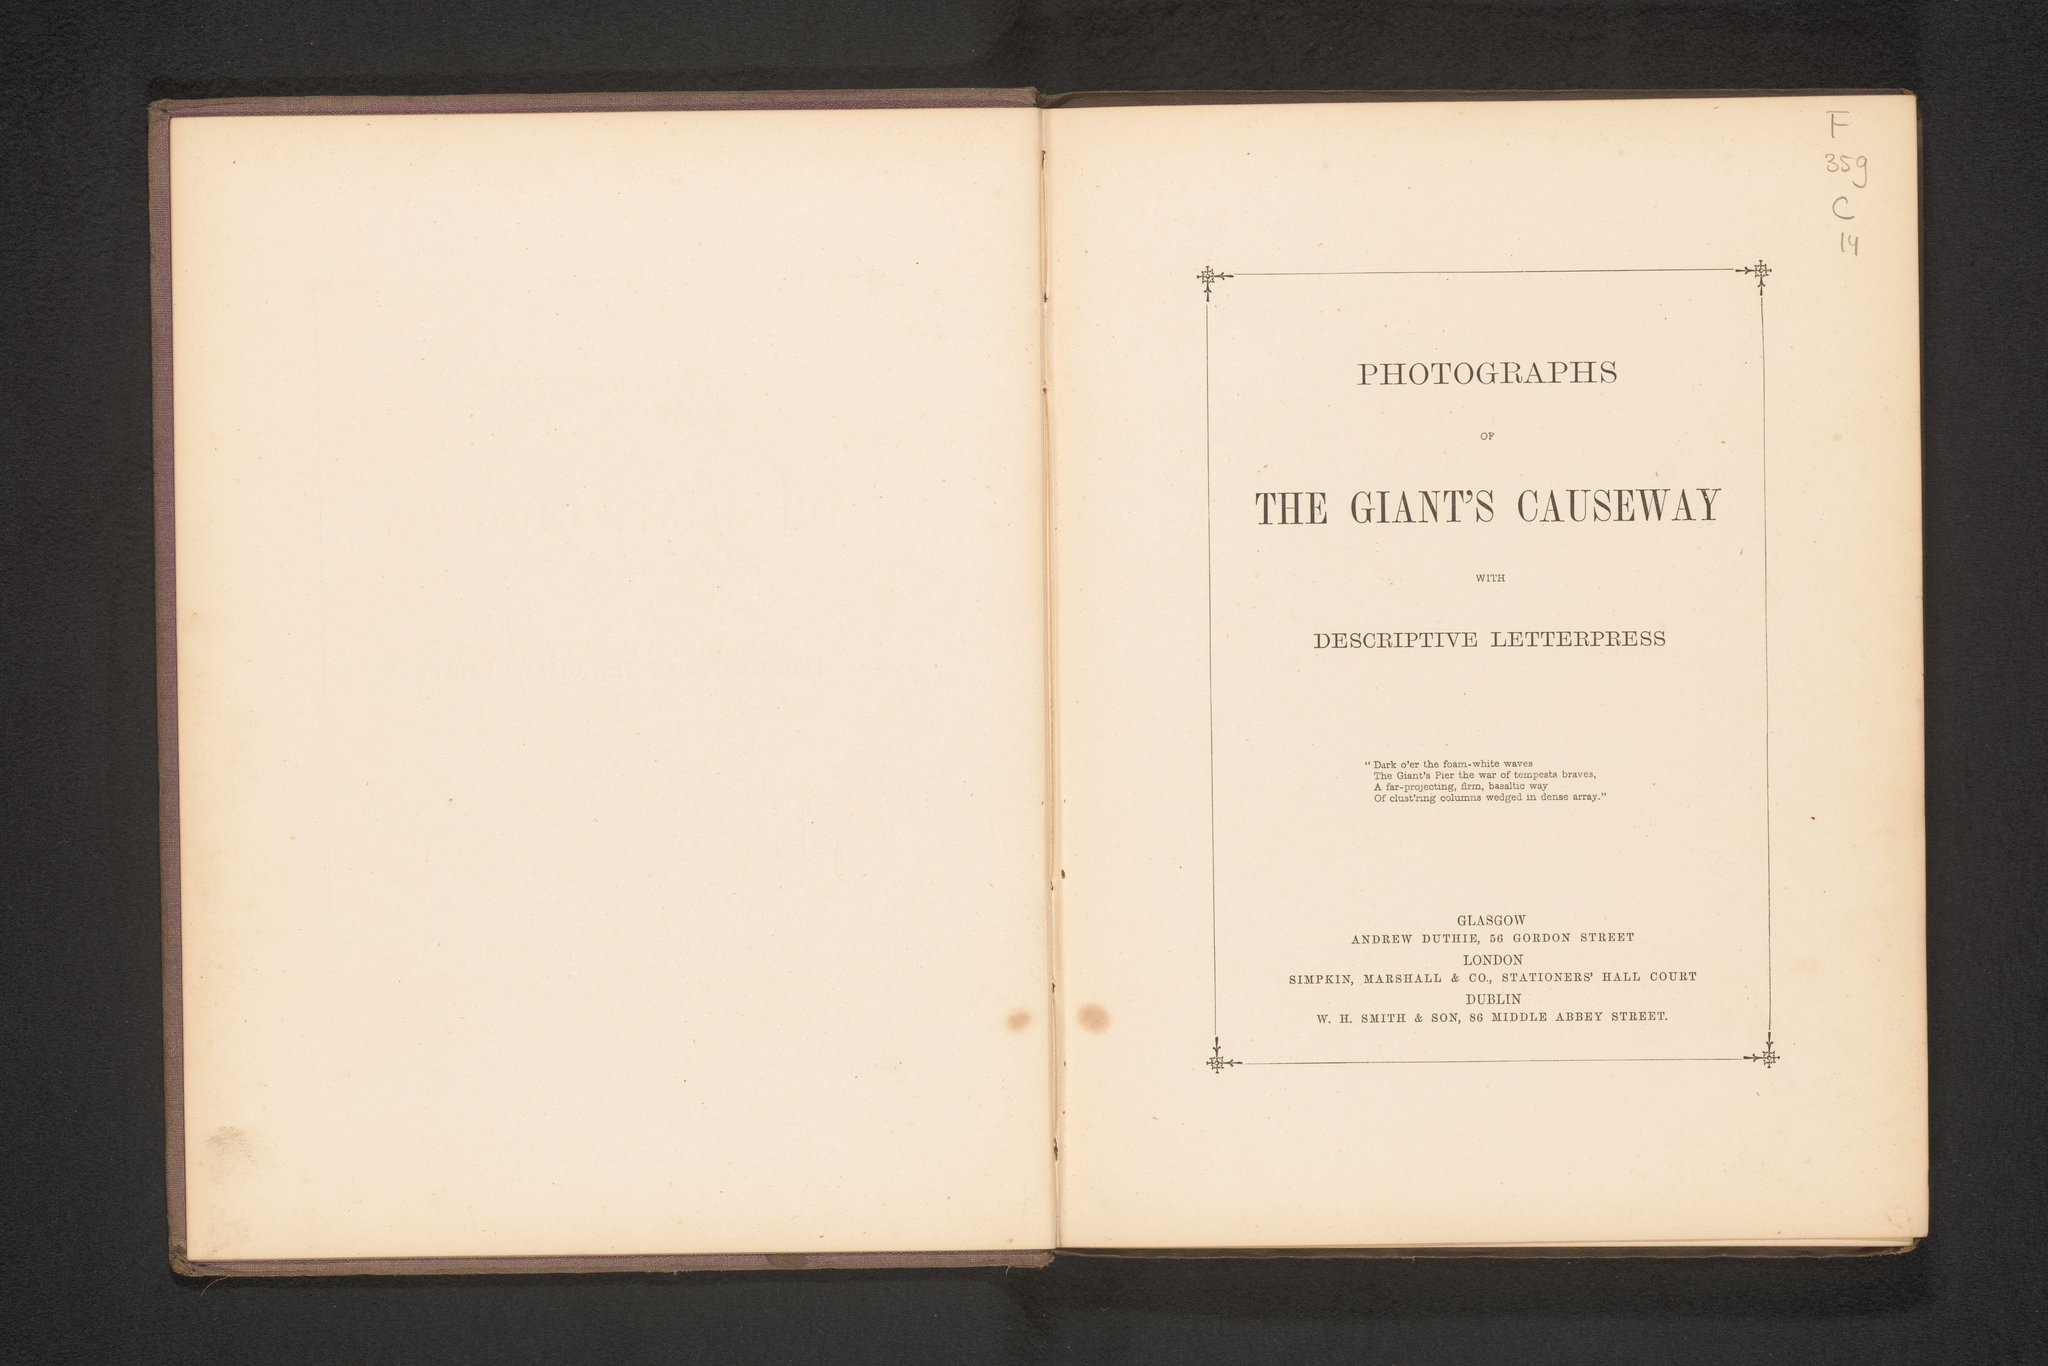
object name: book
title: Photographs of the Giant's Causeway with descriptive letterpress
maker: andrew duthie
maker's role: publisher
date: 1867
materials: cardboard, paper, photographic support, textile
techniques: albumen print, printing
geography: london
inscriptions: annotation: ‘SEPT/1991’, annotation: ‘George/ with Frank's best wishes/ August 26th 1869’